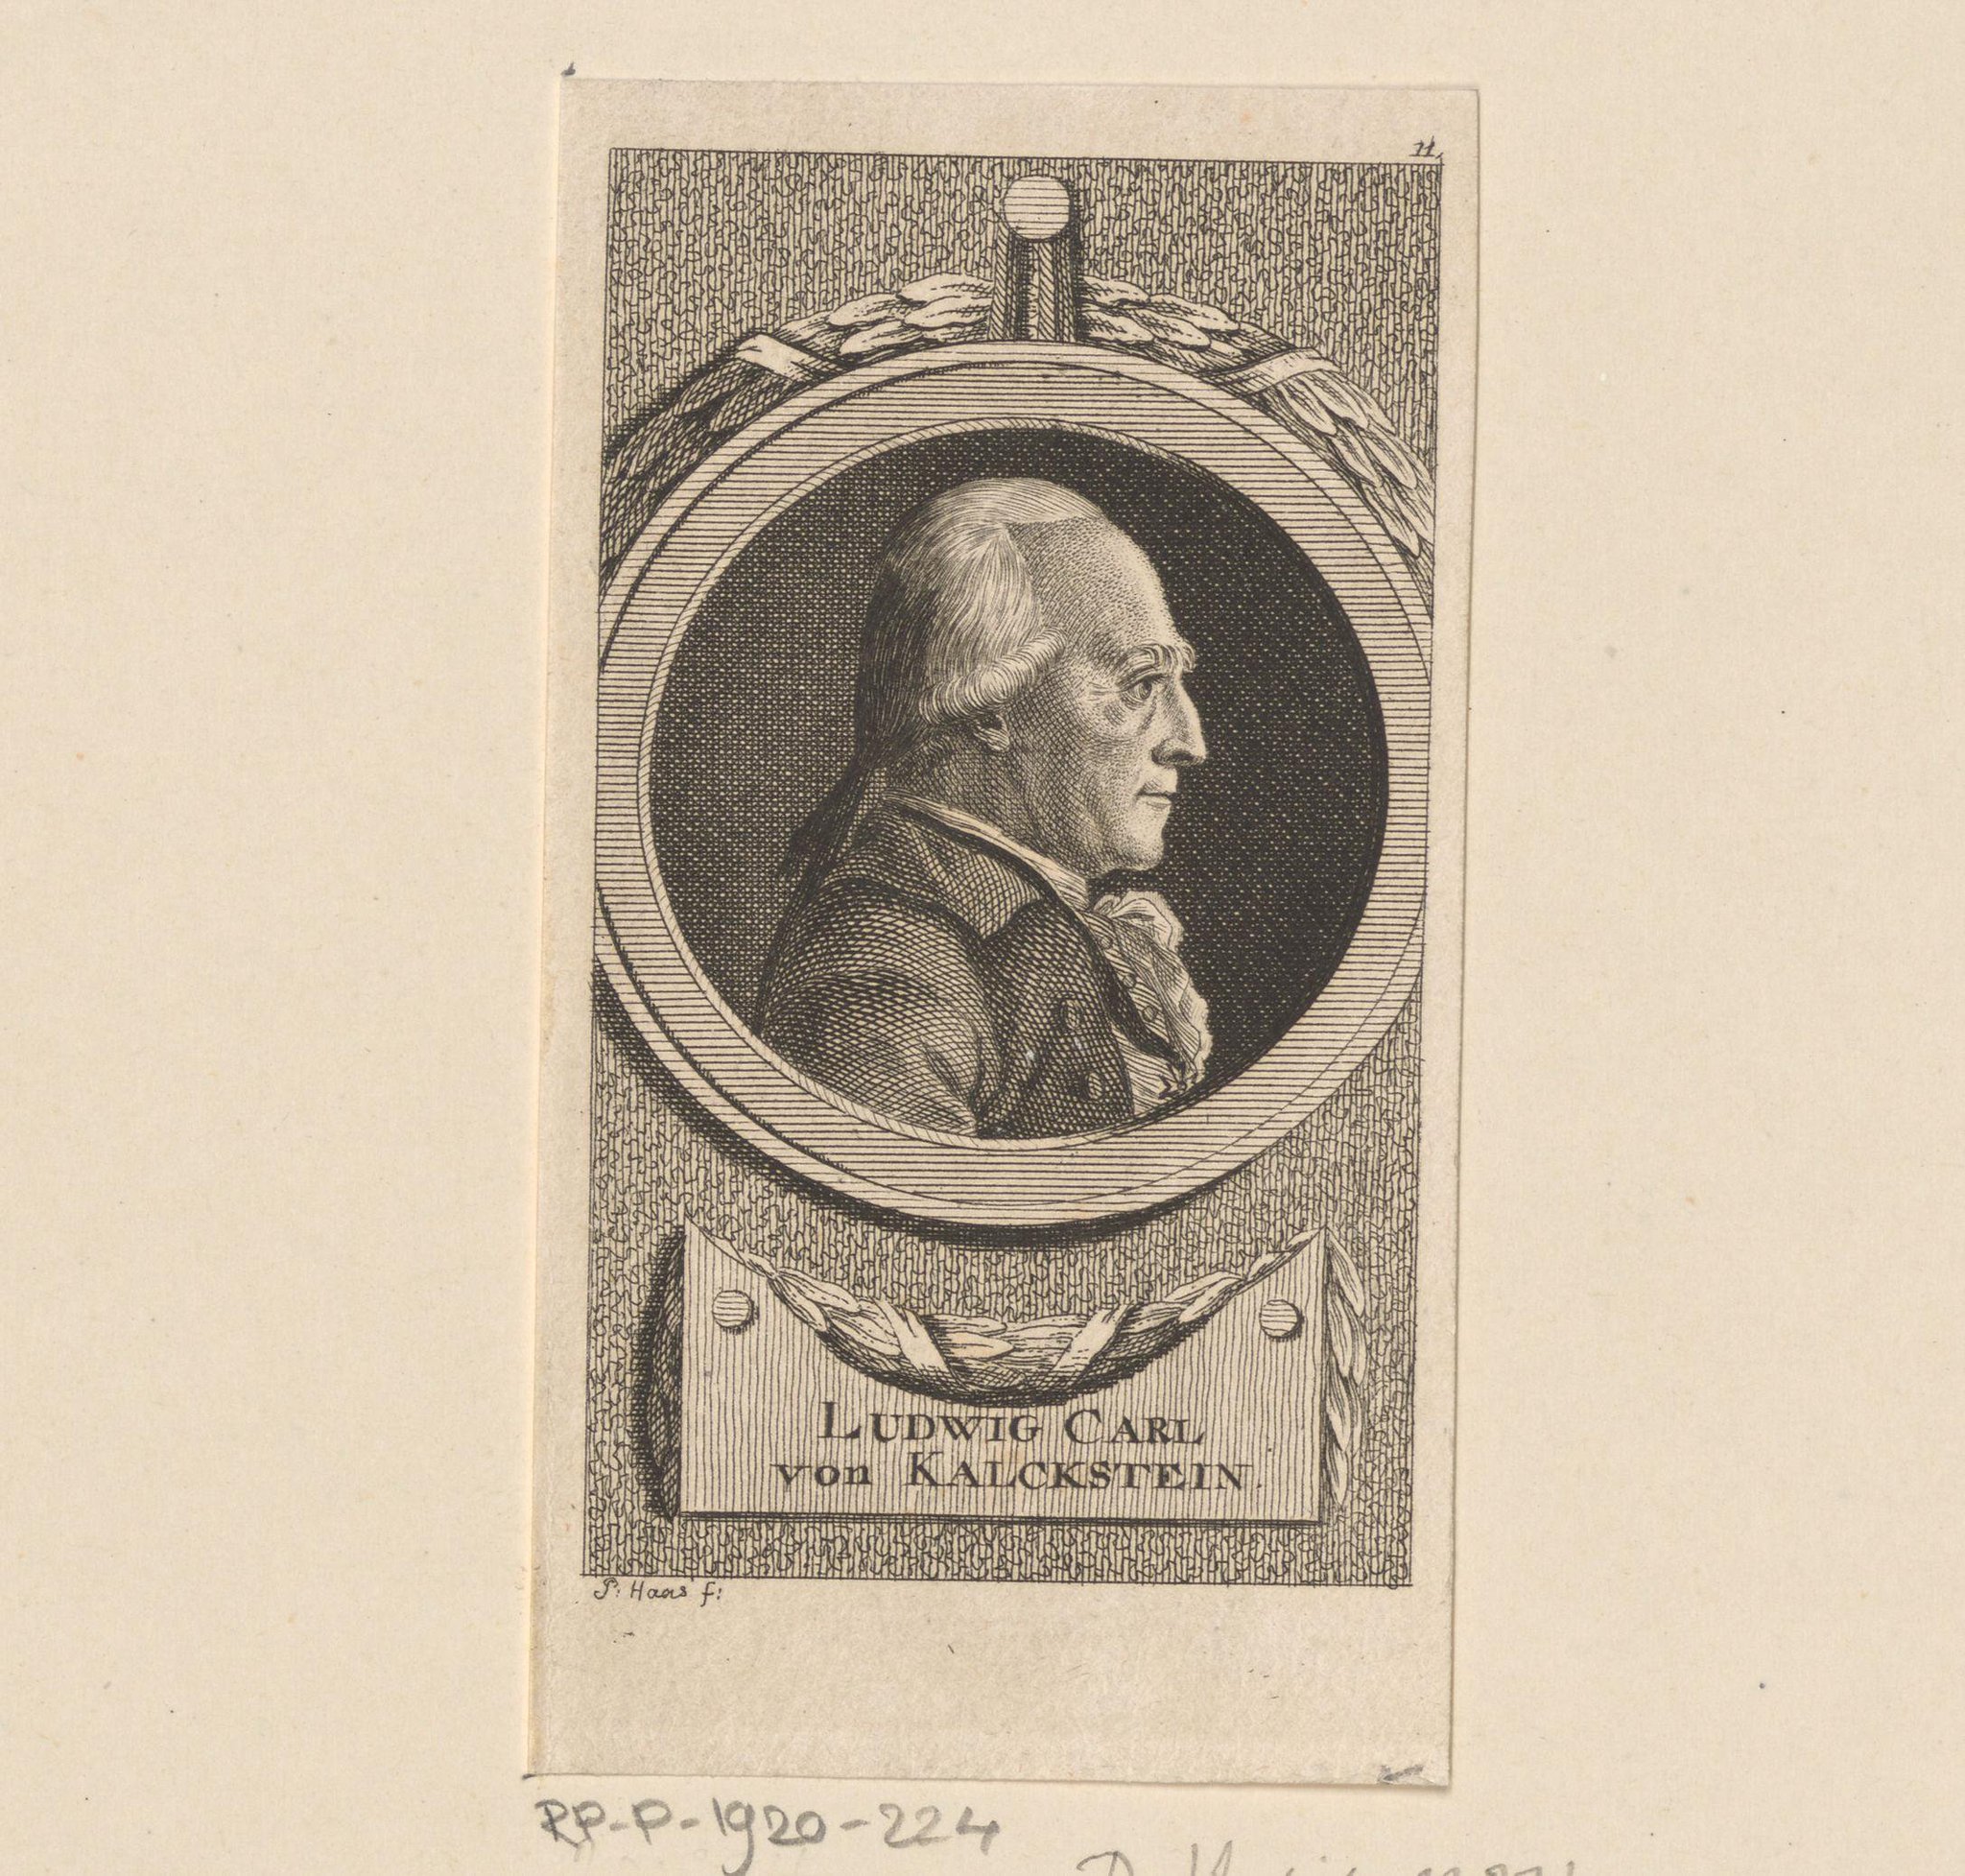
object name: print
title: Portret van Ludwig Karl von Kalckstein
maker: peter haas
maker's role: print maker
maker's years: 1754-1804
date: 1764-1804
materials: paper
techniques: engraving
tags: historical persons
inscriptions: collector's mark: Lugt 2228